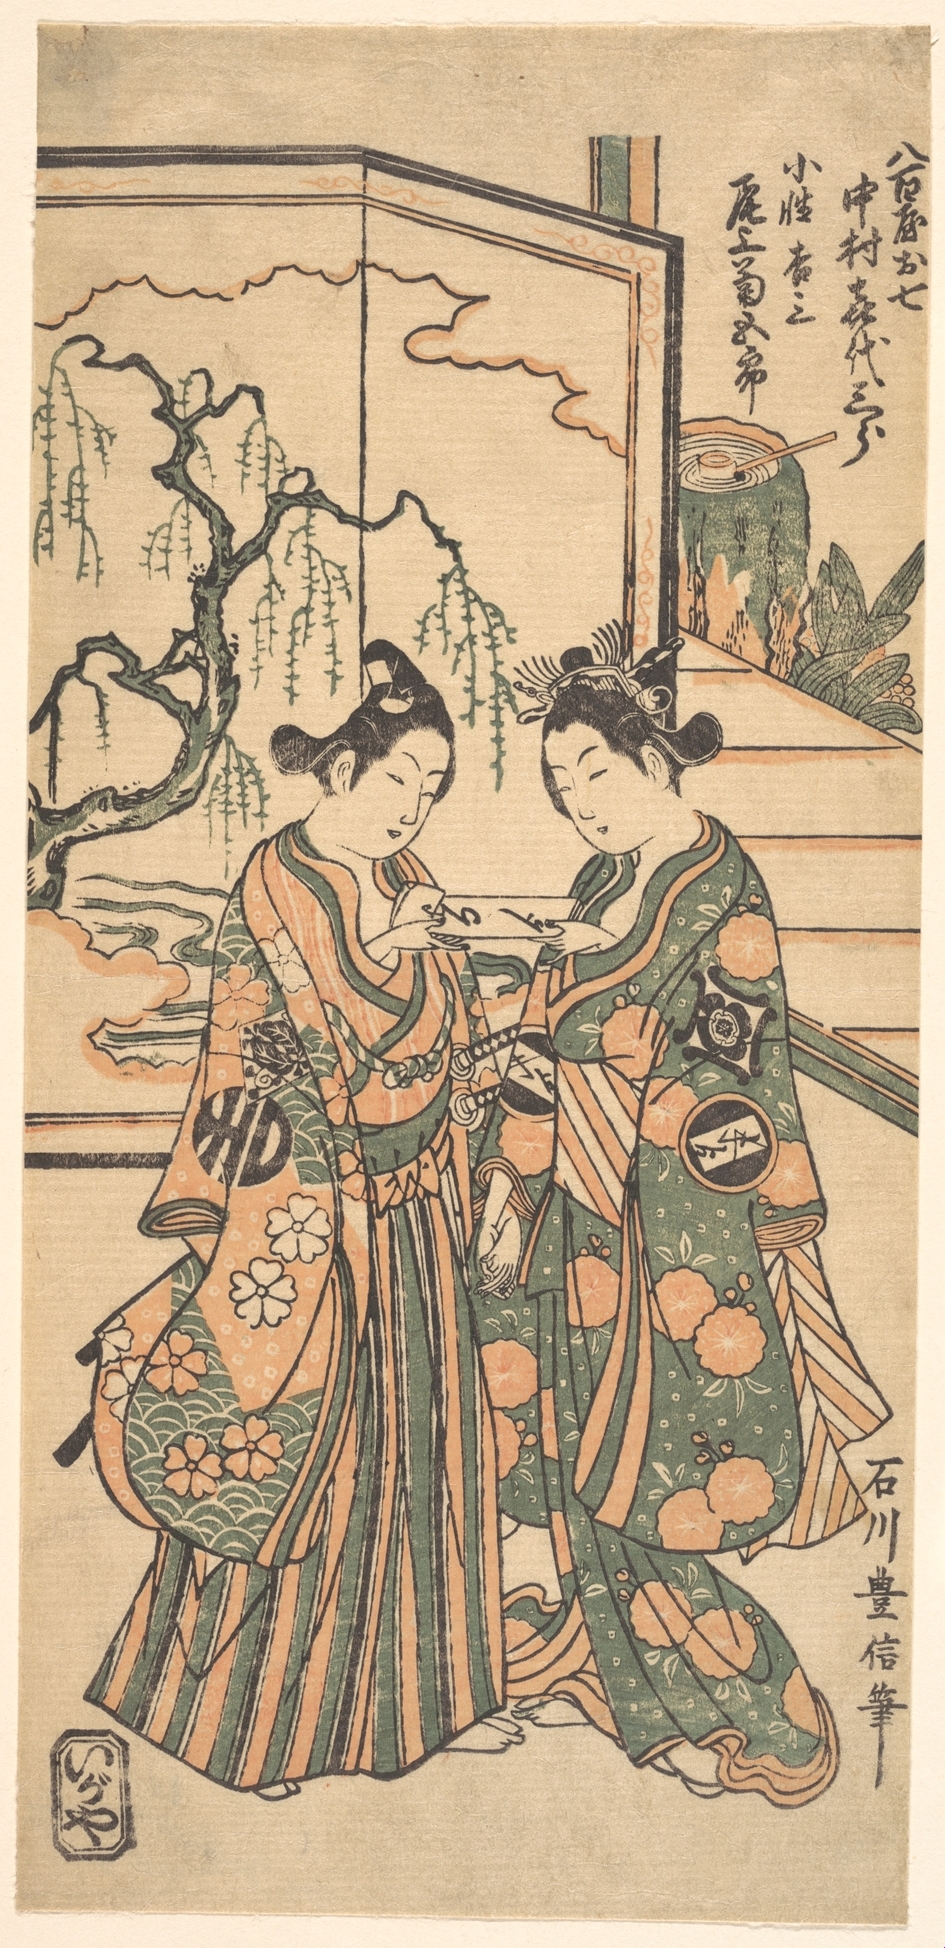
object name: woodblock print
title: Drama of Areshi Soga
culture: japanese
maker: ishikawa toyonobu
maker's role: artist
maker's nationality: japanese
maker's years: 1711-1785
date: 1711-1785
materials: ink, paper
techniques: woodblock print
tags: women,trees,actors